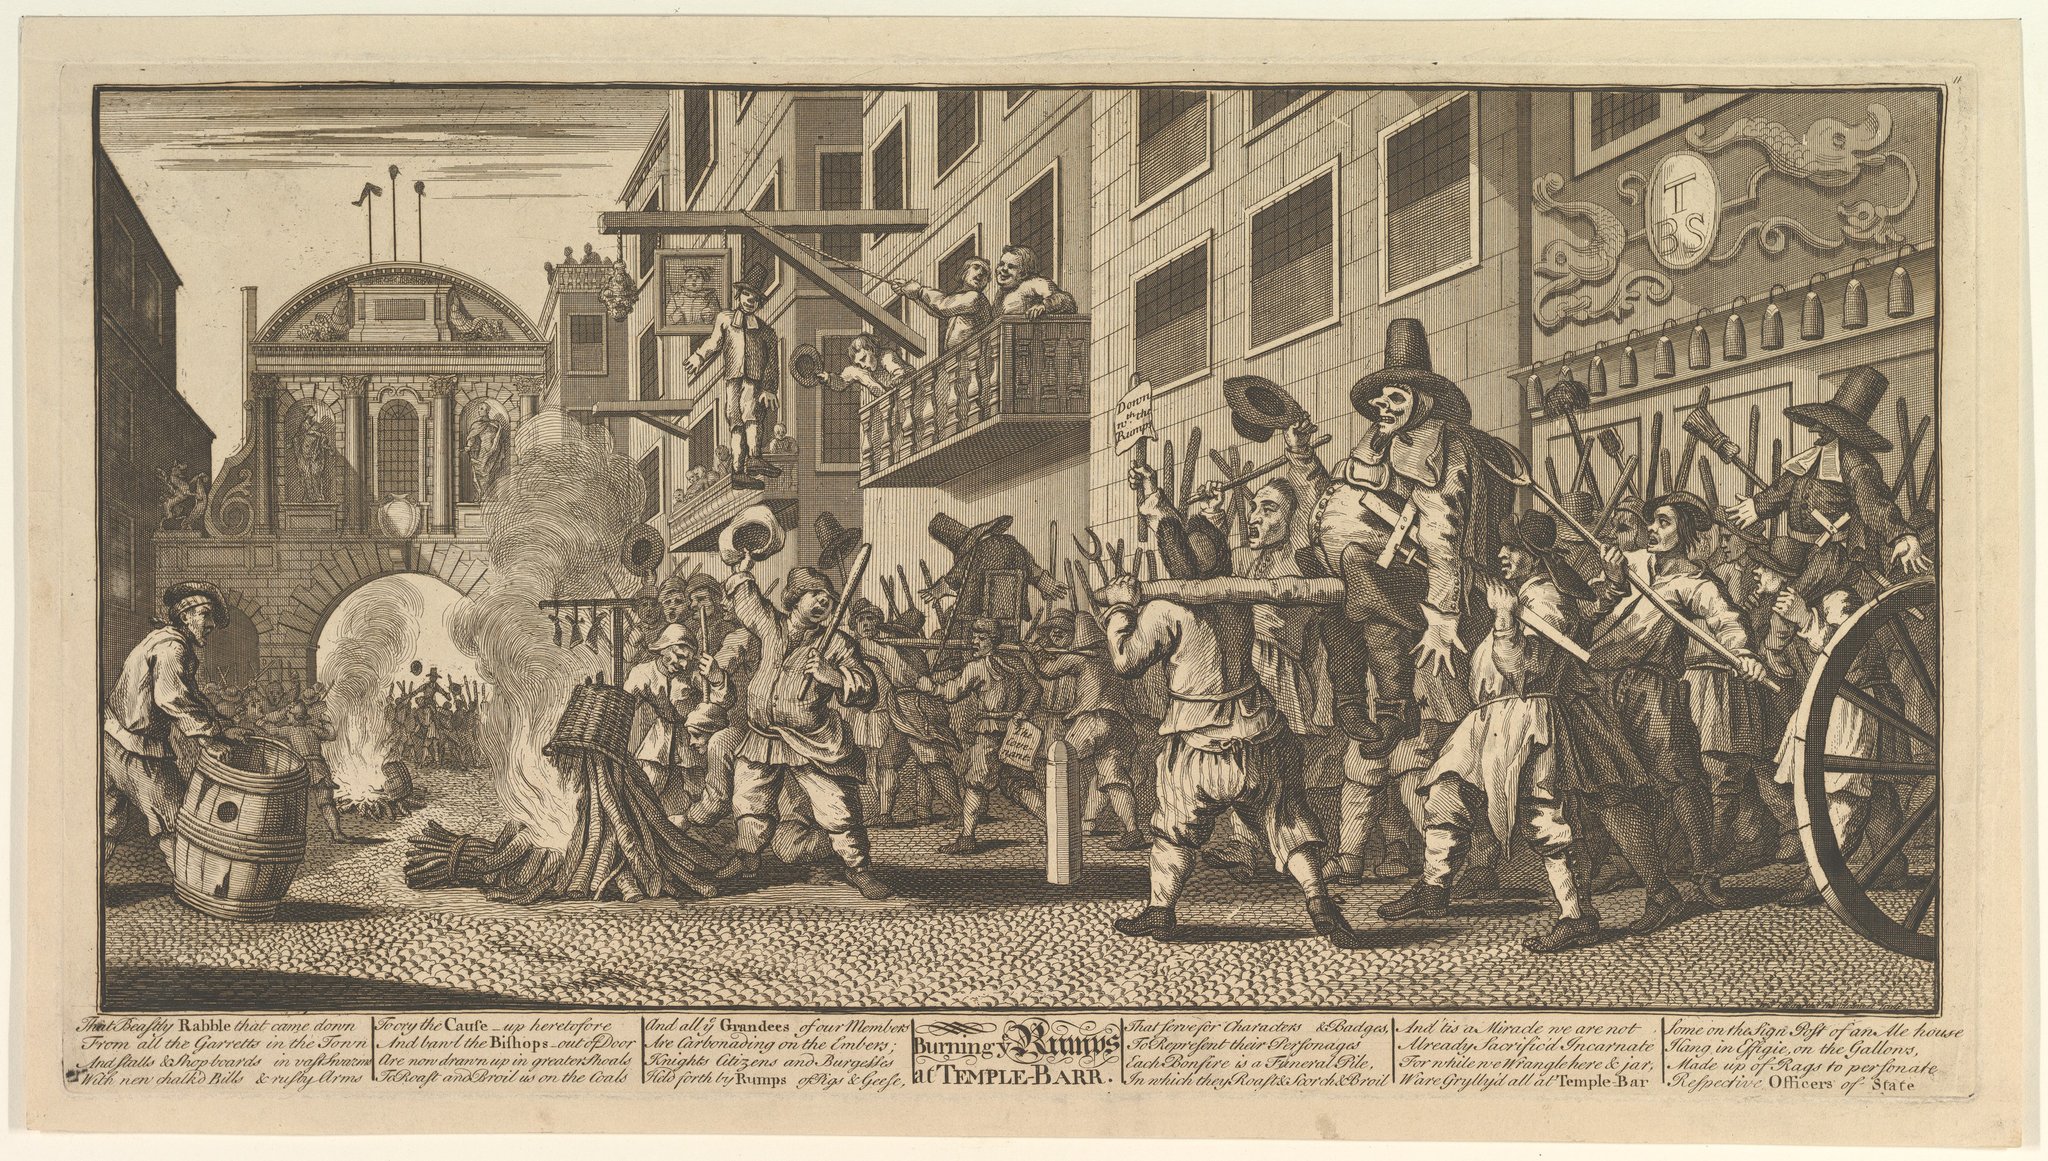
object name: print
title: Burning the Rumps at Temple Bar (Twelve Large Illustrations for Samuel Butler's Hudibras, Plate 11)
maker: william hogarth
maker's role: artist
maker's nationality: british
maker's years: 1697-1764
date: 1725-1768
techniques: engraving, etching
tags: men,fire